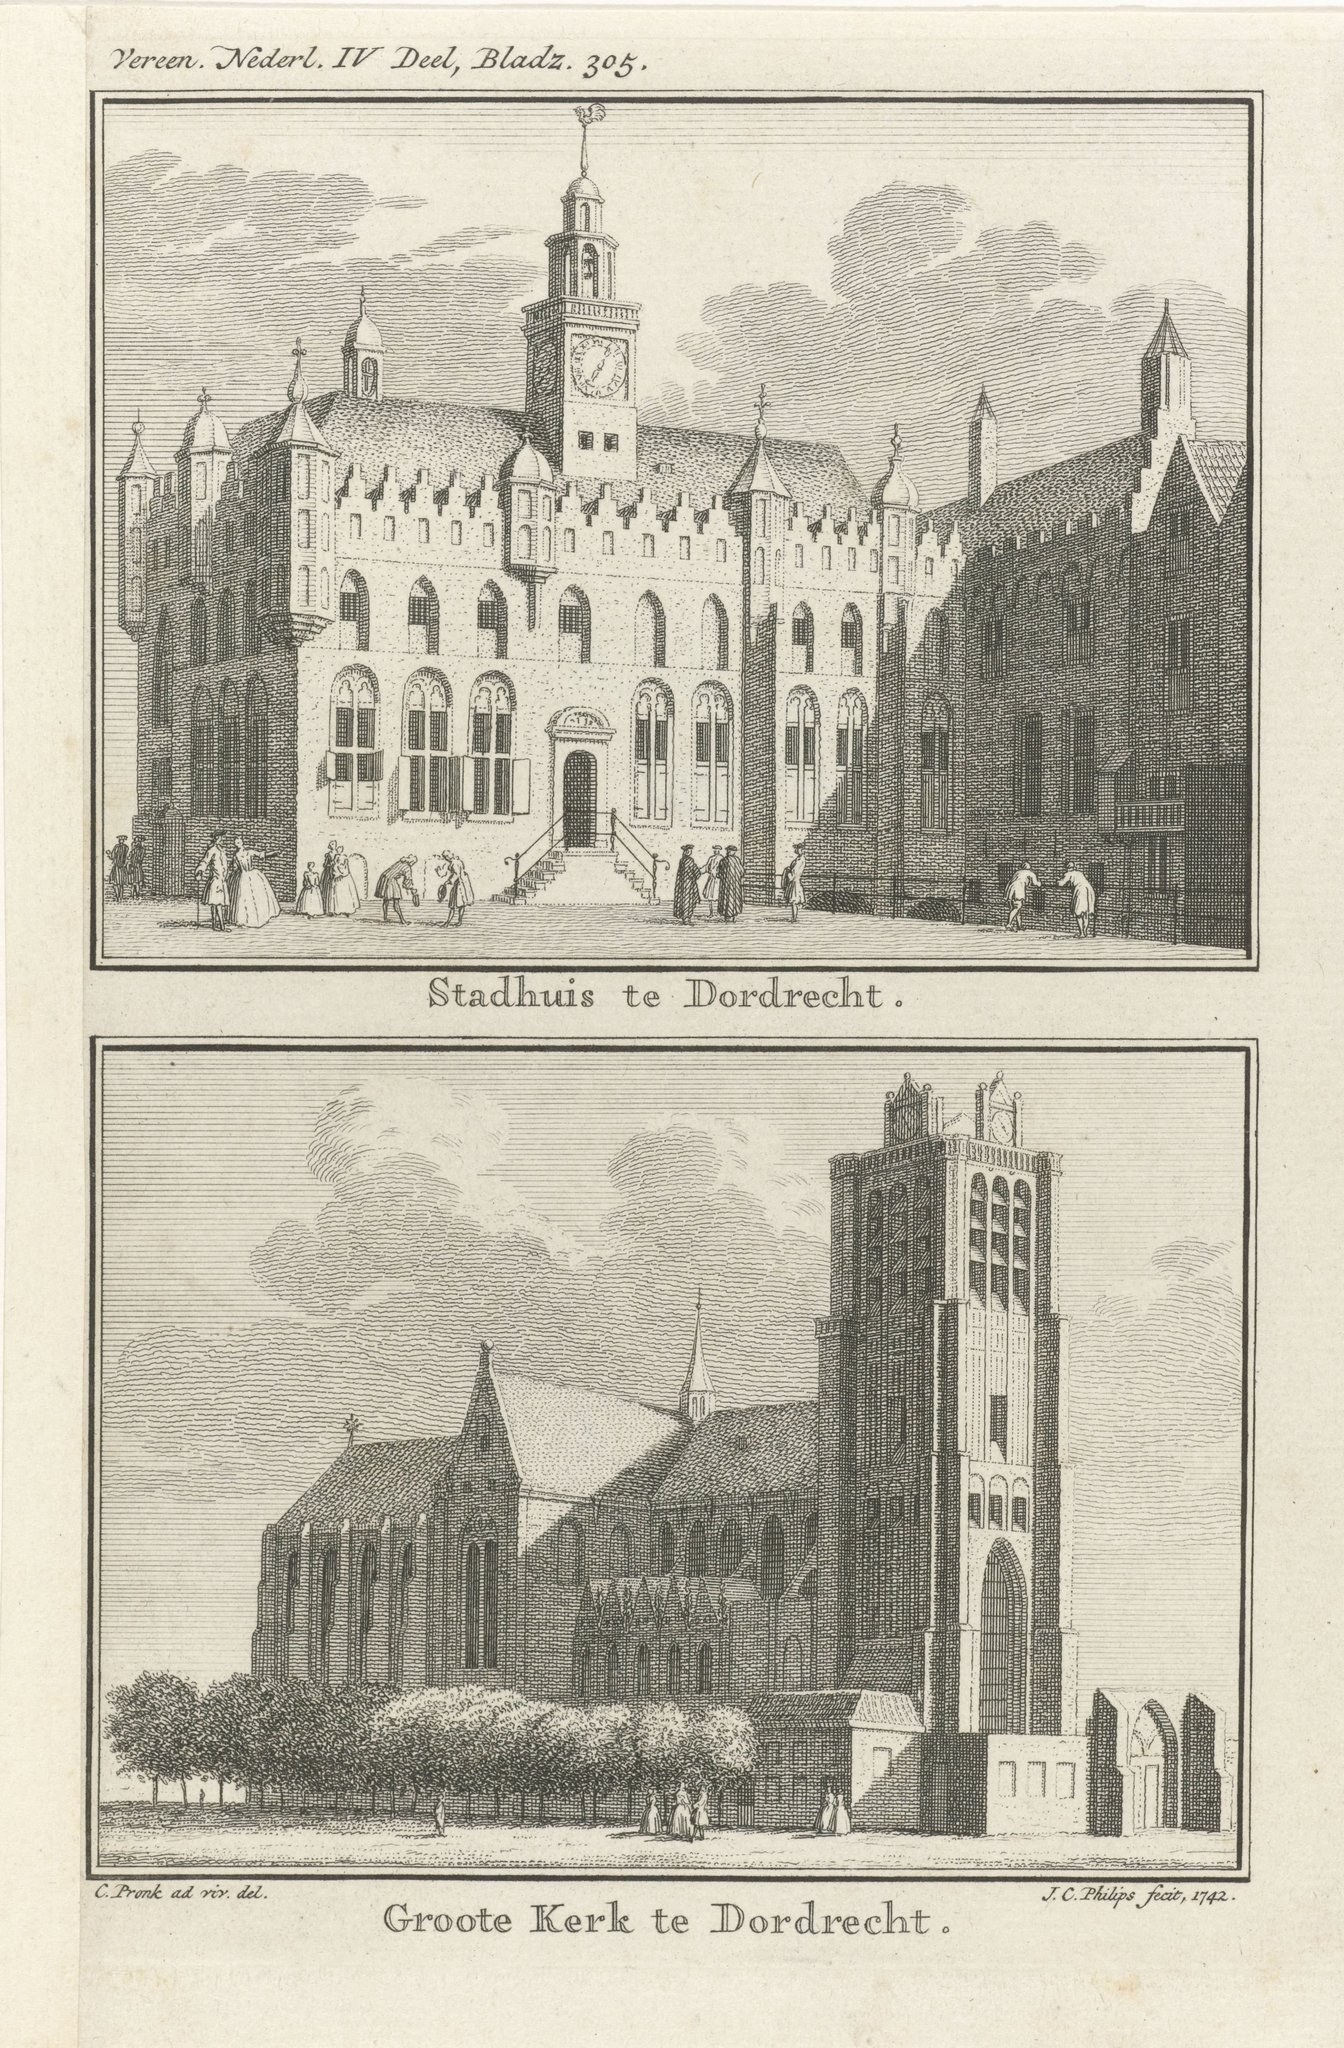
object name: book illustration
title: Stadhuis te Dordrecht / Groote Kerk te Dordrecht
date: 1742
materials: paper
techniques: etching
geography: amsterdam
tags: church (exterior), townhall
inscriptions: collector's mark: Lugt 2228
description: Twee voorstellingen op één blad. Boven: het stadhuis van Dordrecht. Onder: de Grote Kerk te Dordrecht.